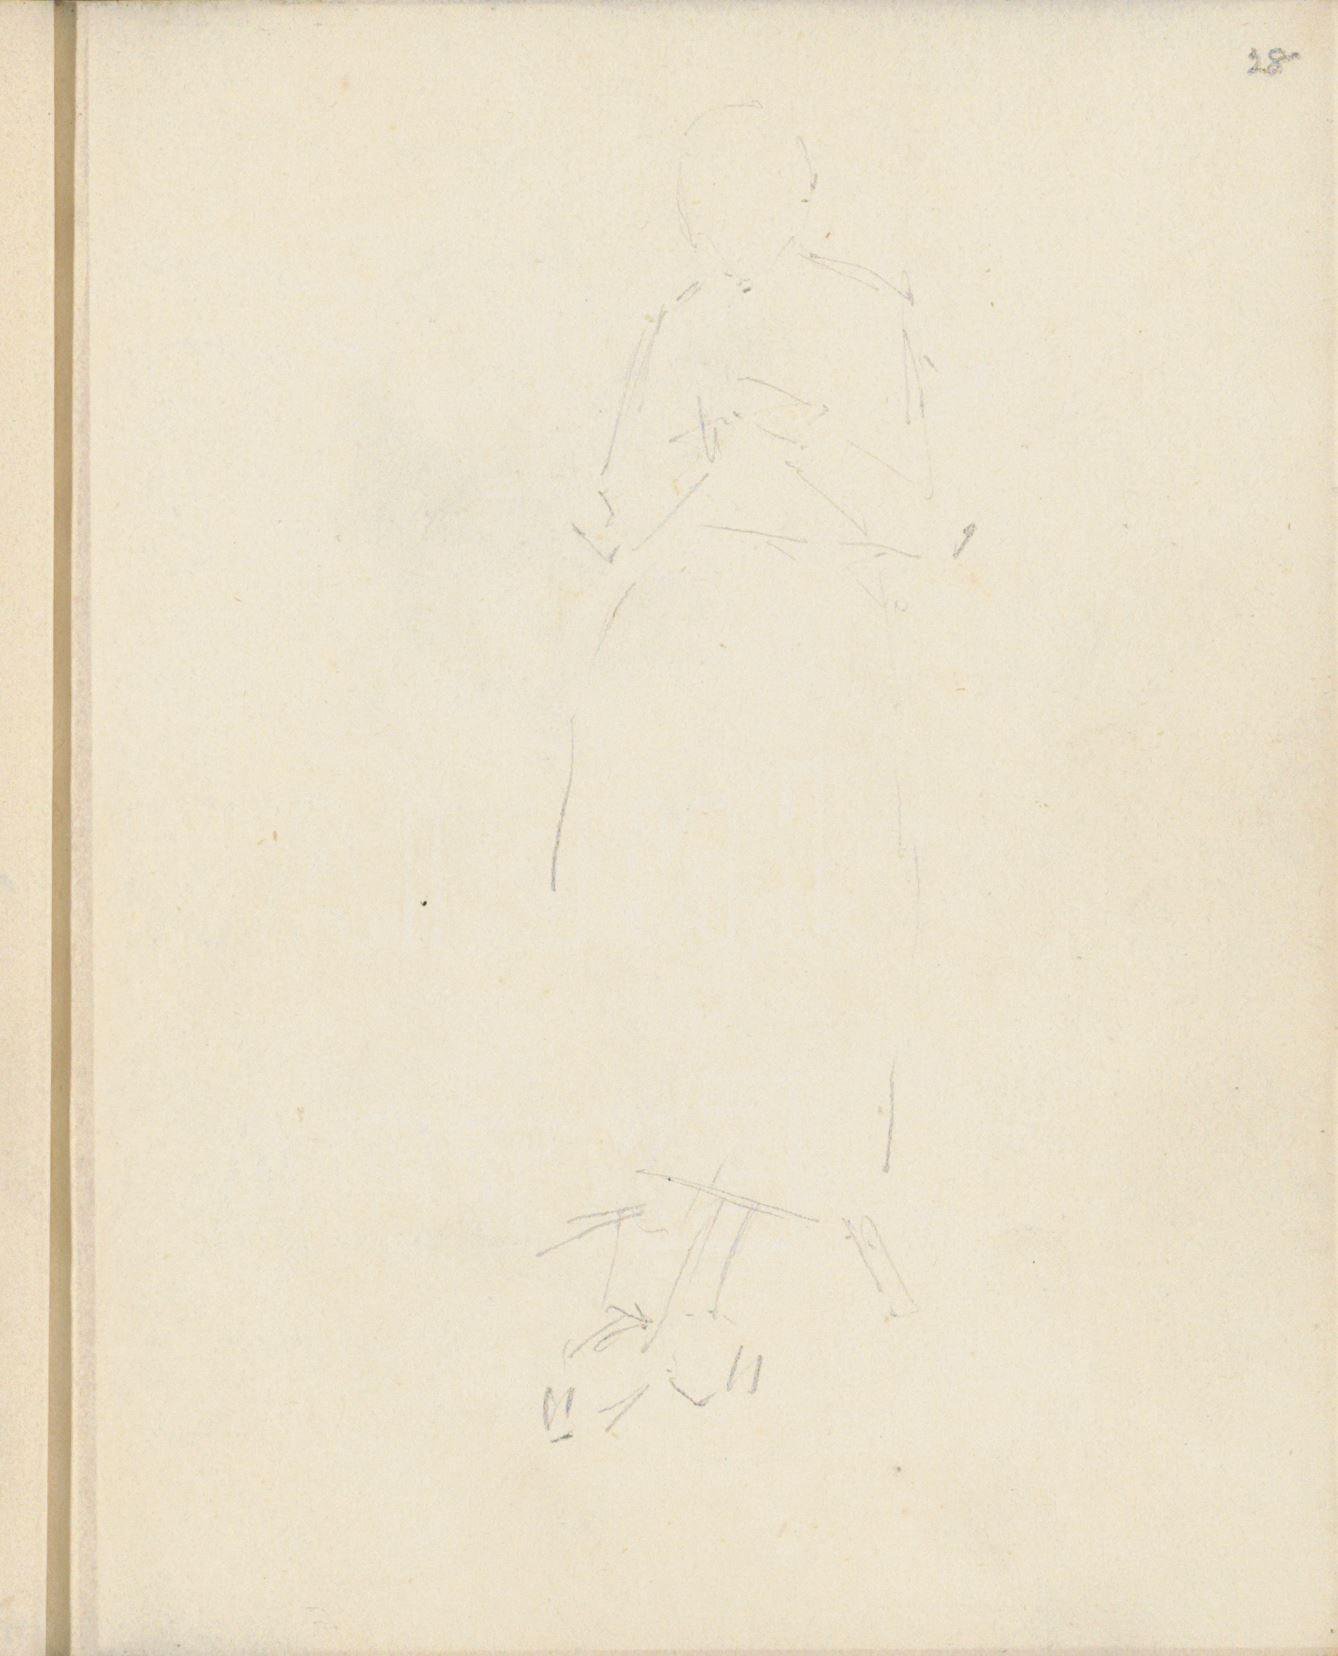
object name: sketchbook leaf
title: Staande vrouw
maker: alfred william rich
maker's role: draughtsman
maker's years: 1856-1921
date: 1892-1893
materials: paper, pencil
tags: standing figure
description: Blad 28 recto uit een schetsboek met 86 bladen.